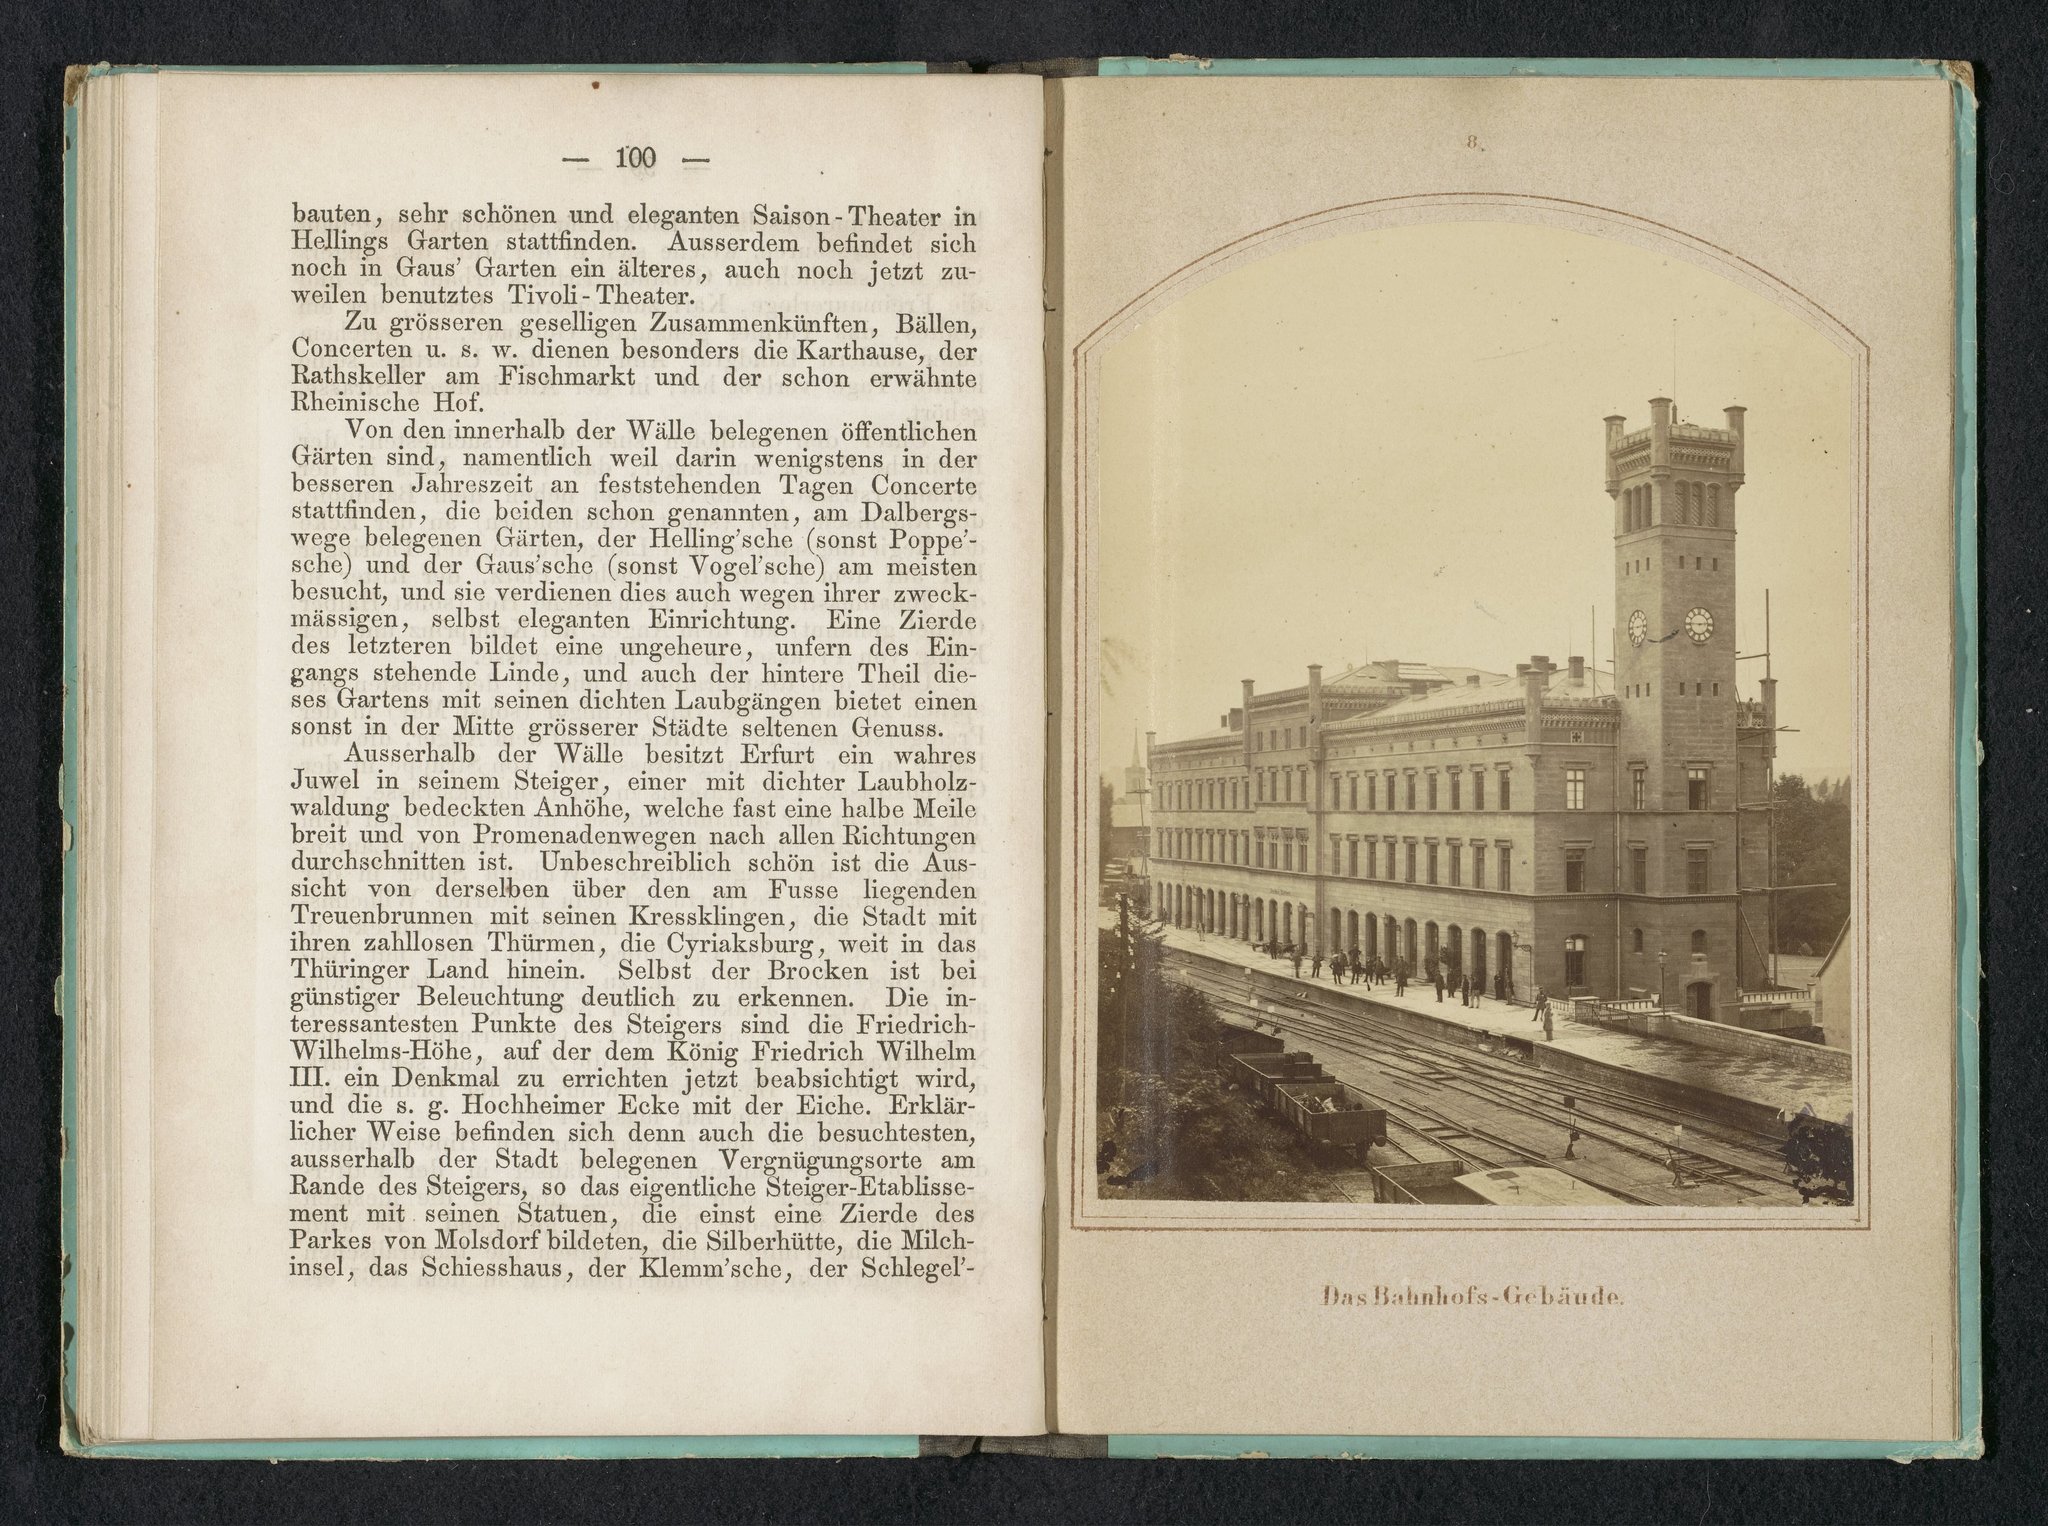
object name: photograph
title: Das Bahnhof-Gebäude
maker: Anonymous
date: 1858-1868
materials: photographic support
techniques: albumen print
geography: erfurt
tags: façade (of house or building), station; shelter (railway, tramway)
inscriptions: number: ‘8.’